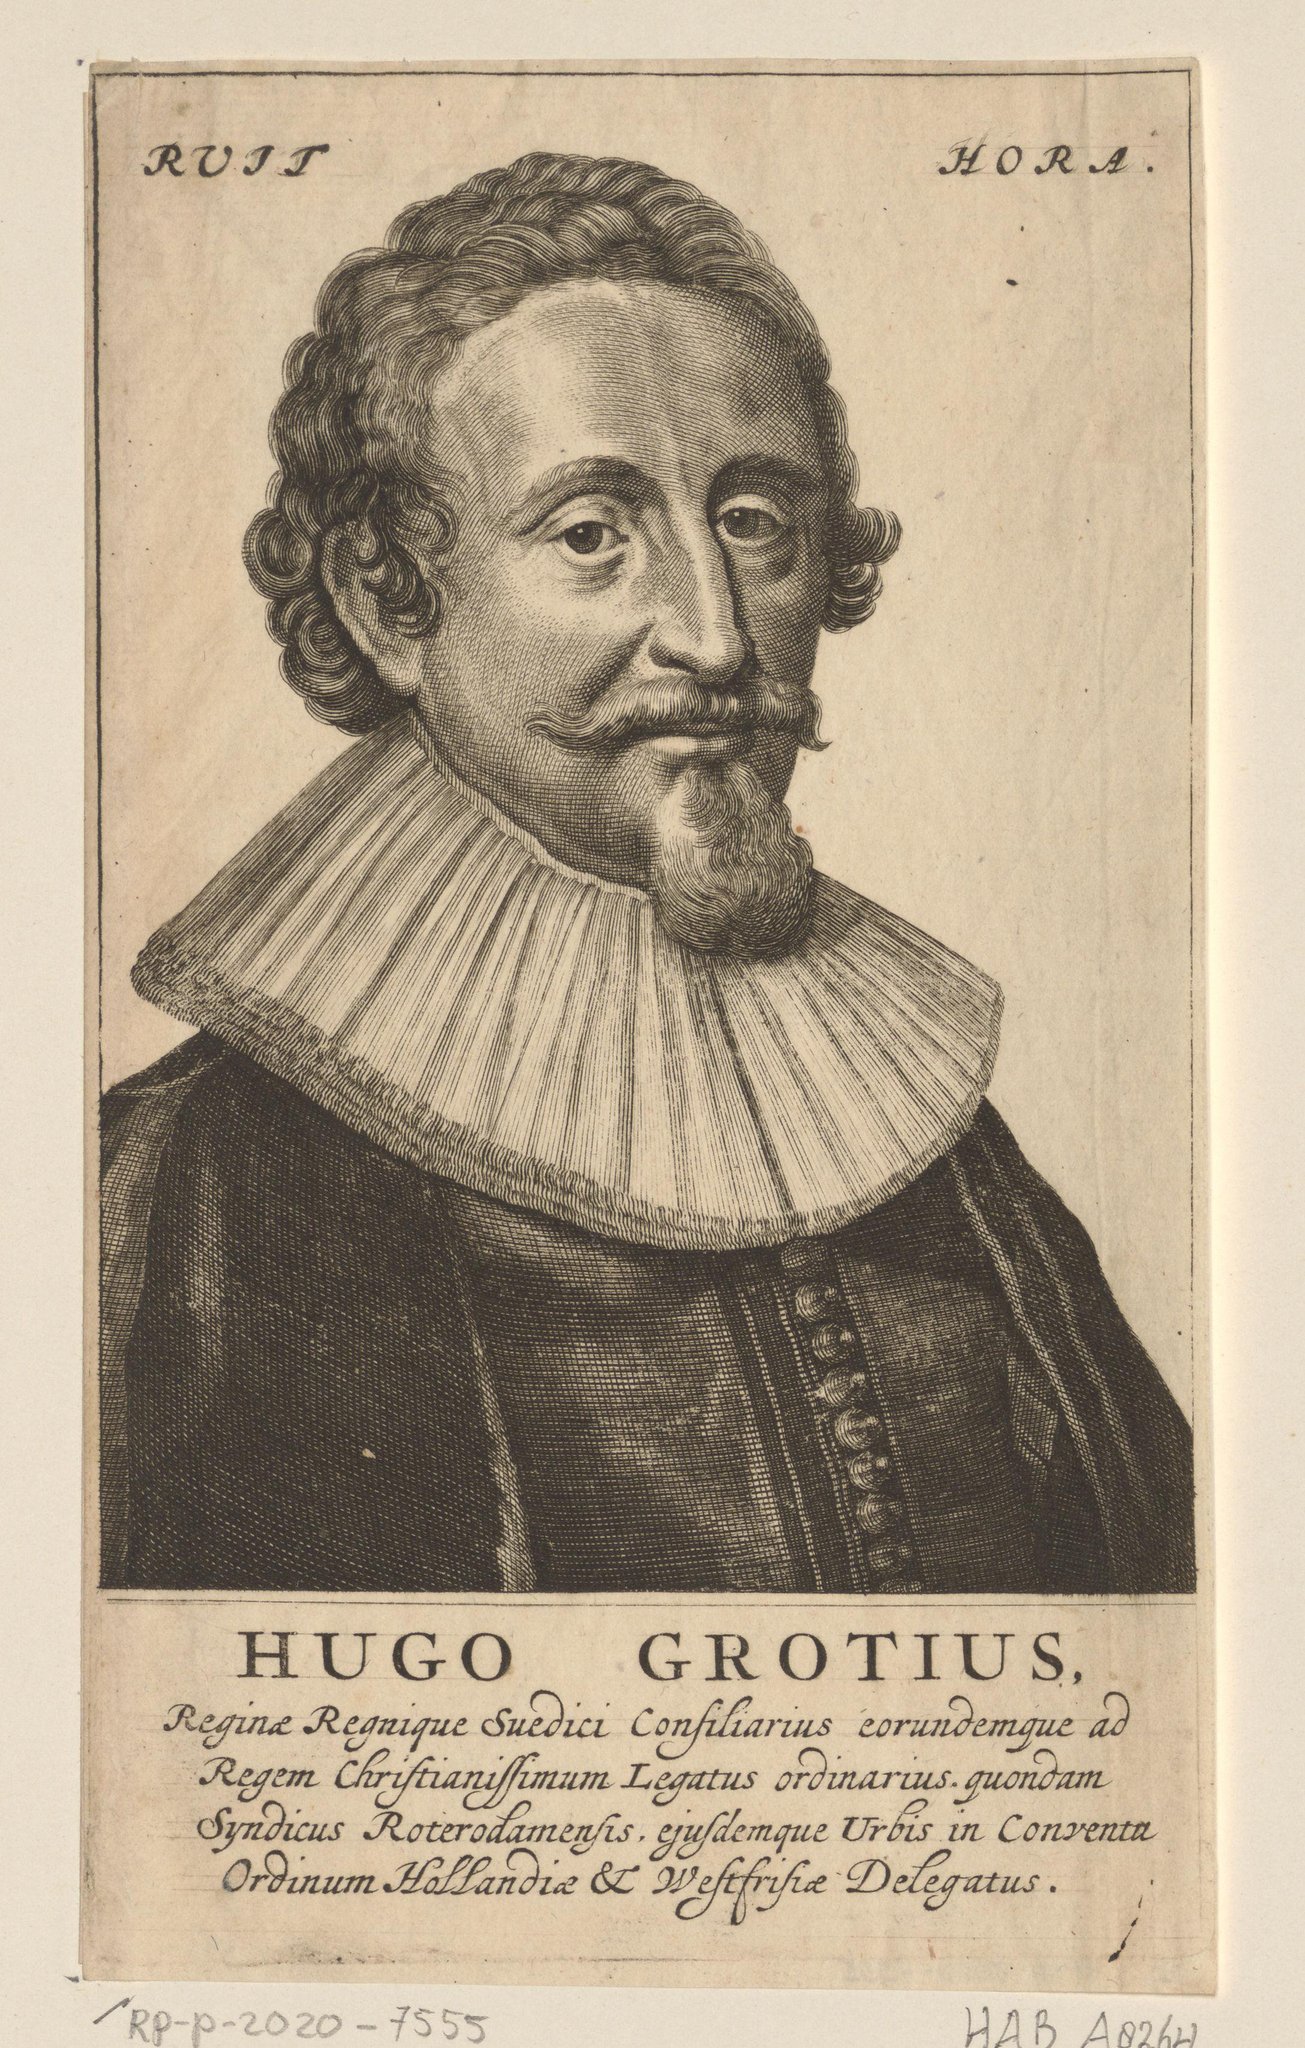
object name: print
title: Portret van Hugo de Groot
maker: Anonymous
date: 1658-1670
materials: paper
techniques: engraving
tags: hugo de groot, historical persons, portrait of a writer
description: Andere staat met tekst op verso uit: Groot, Hugo de. Annales et historiae de rebus Belgicis. Amsterdam: Johannes Blauw, [1658-1670].